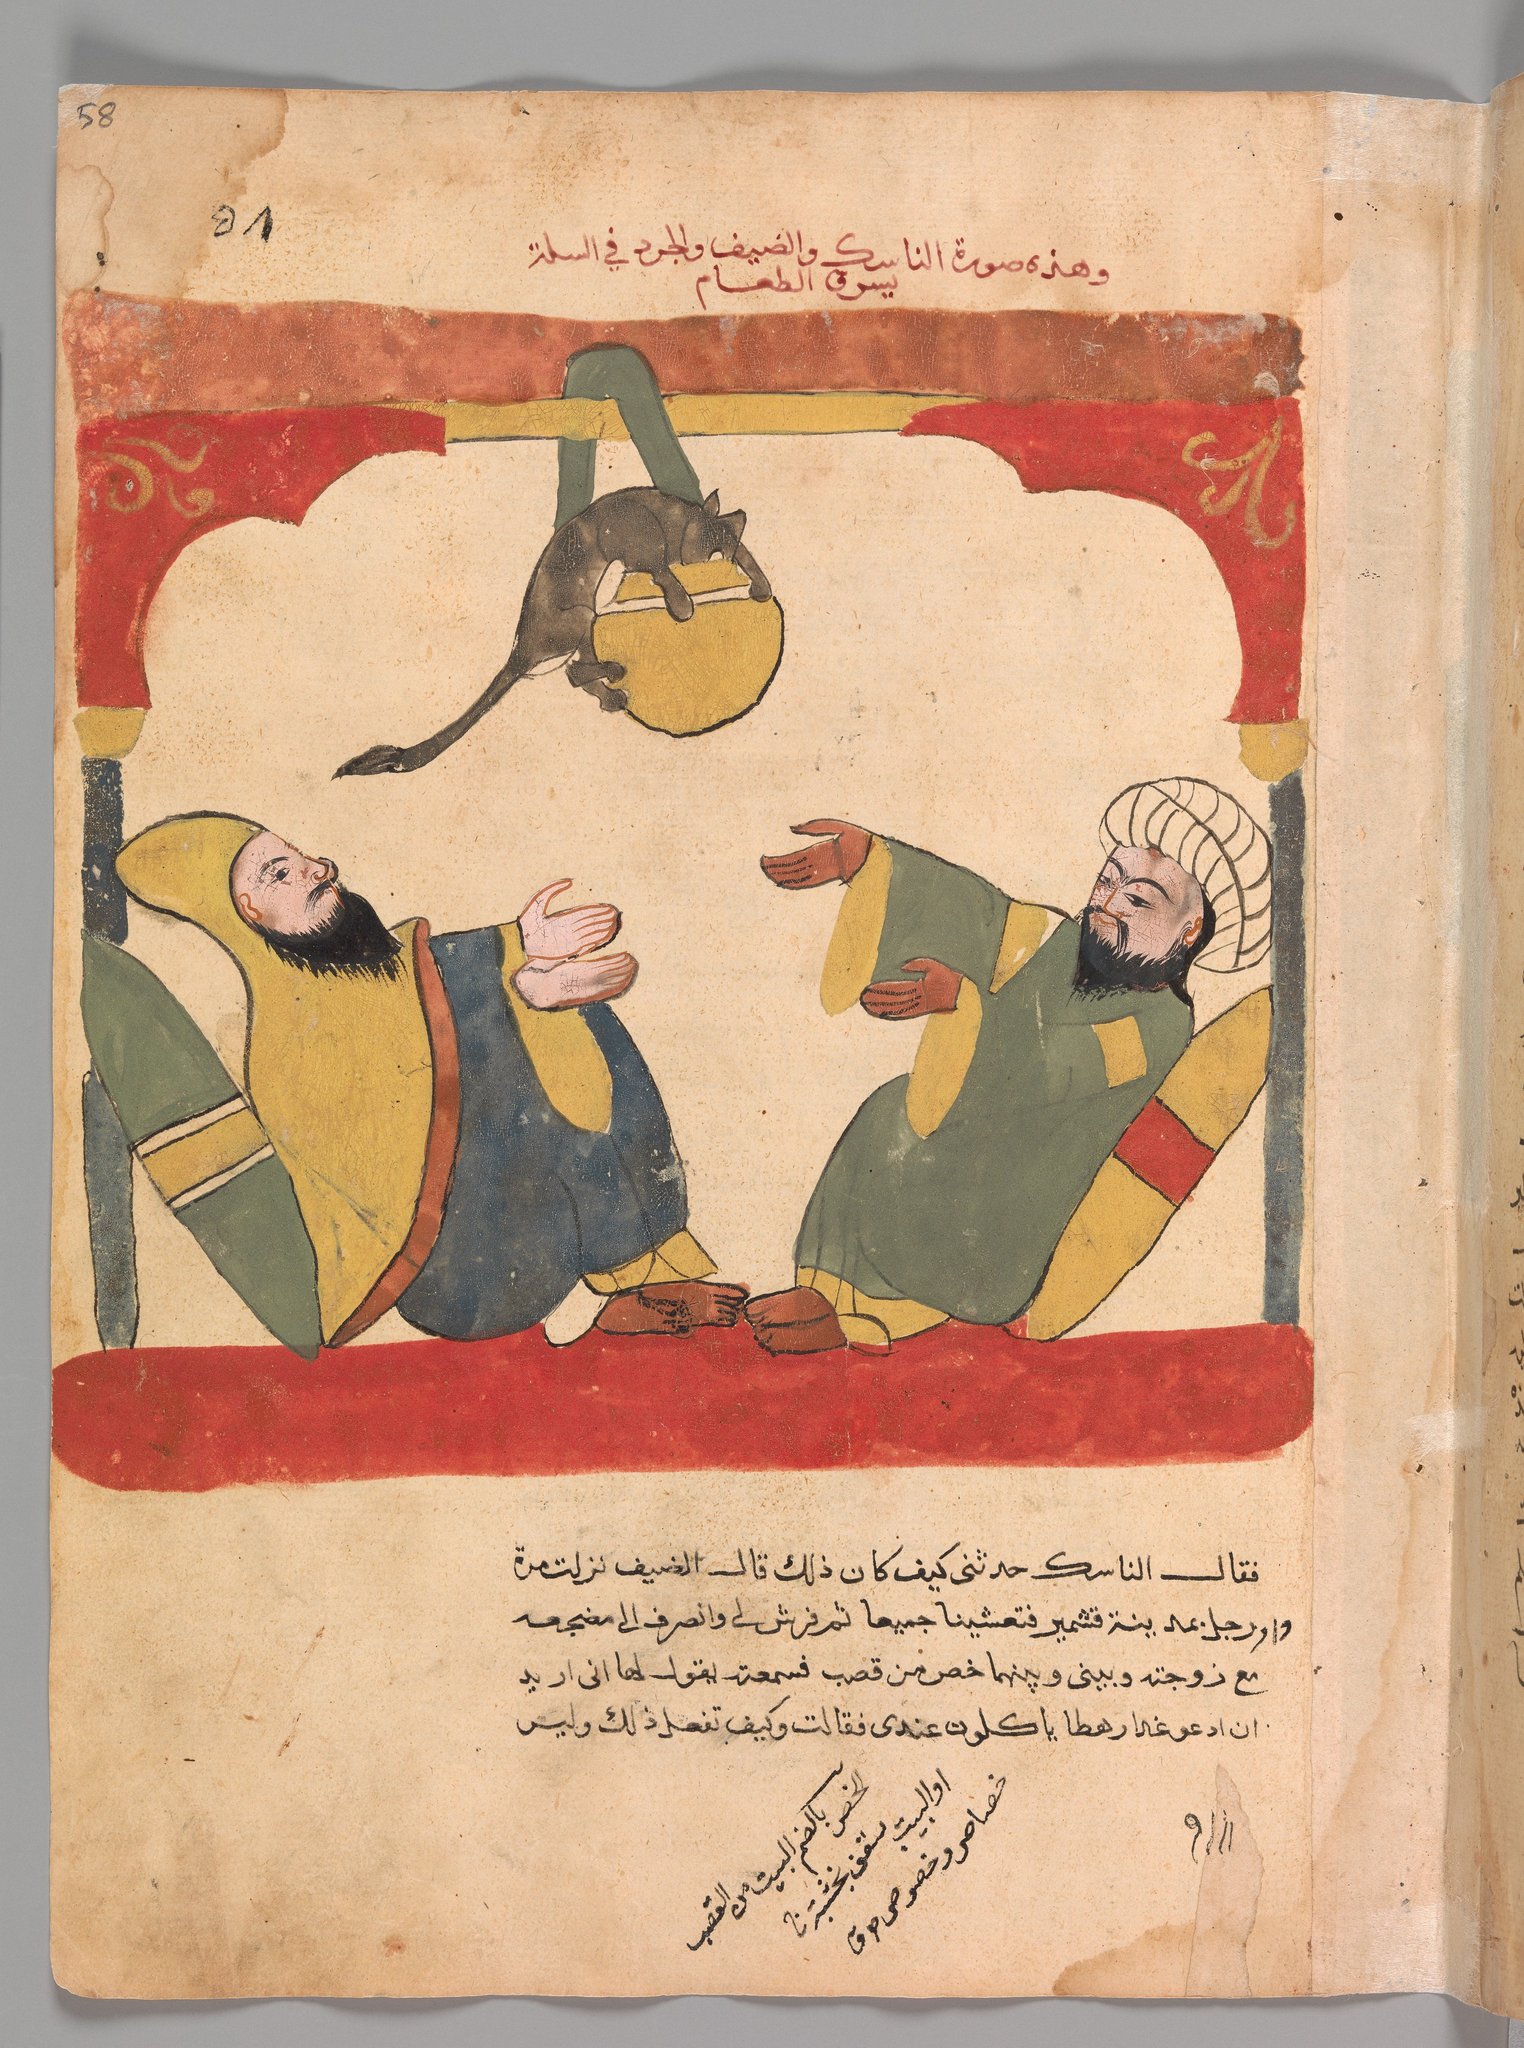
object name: folio from an illustrated manuscript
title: "The Ascetic and his Guest with the Mouse Steal the Ascetic's Food", Folio from a Kalila wa Dimna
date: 1526-1550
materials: ink, paper, watercolor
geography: india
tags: men,mice